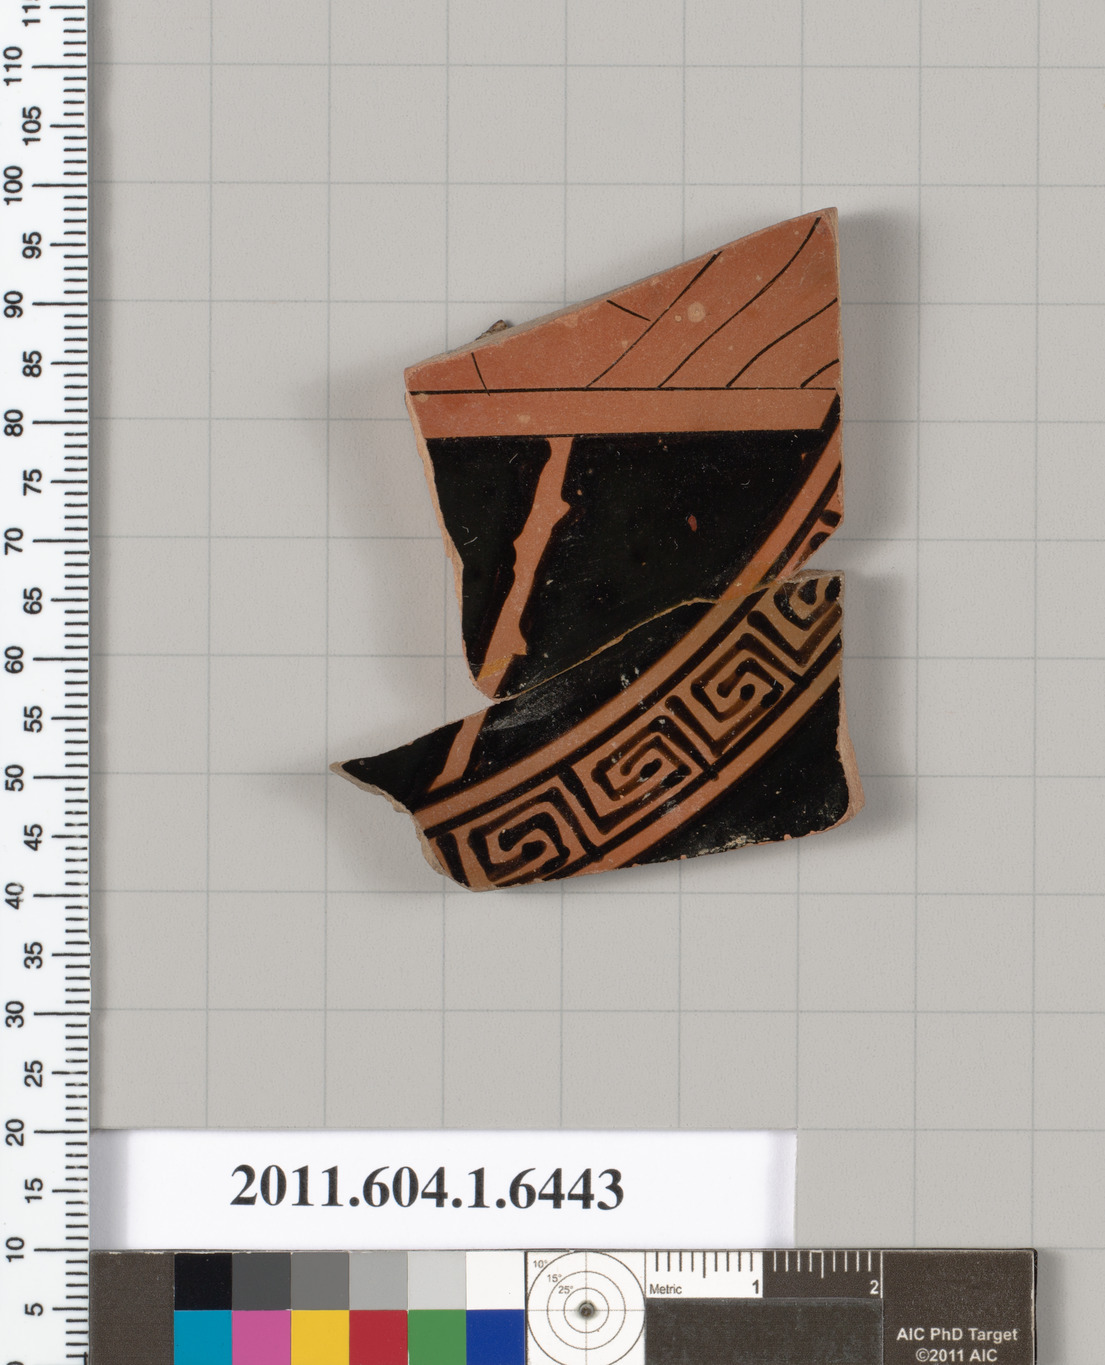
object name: kylix fragment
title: Terracotta fragment of a kylix (drinking cup)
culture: greek, attic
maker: cage painter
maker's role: artist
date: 490-480 BCE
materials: terracotta